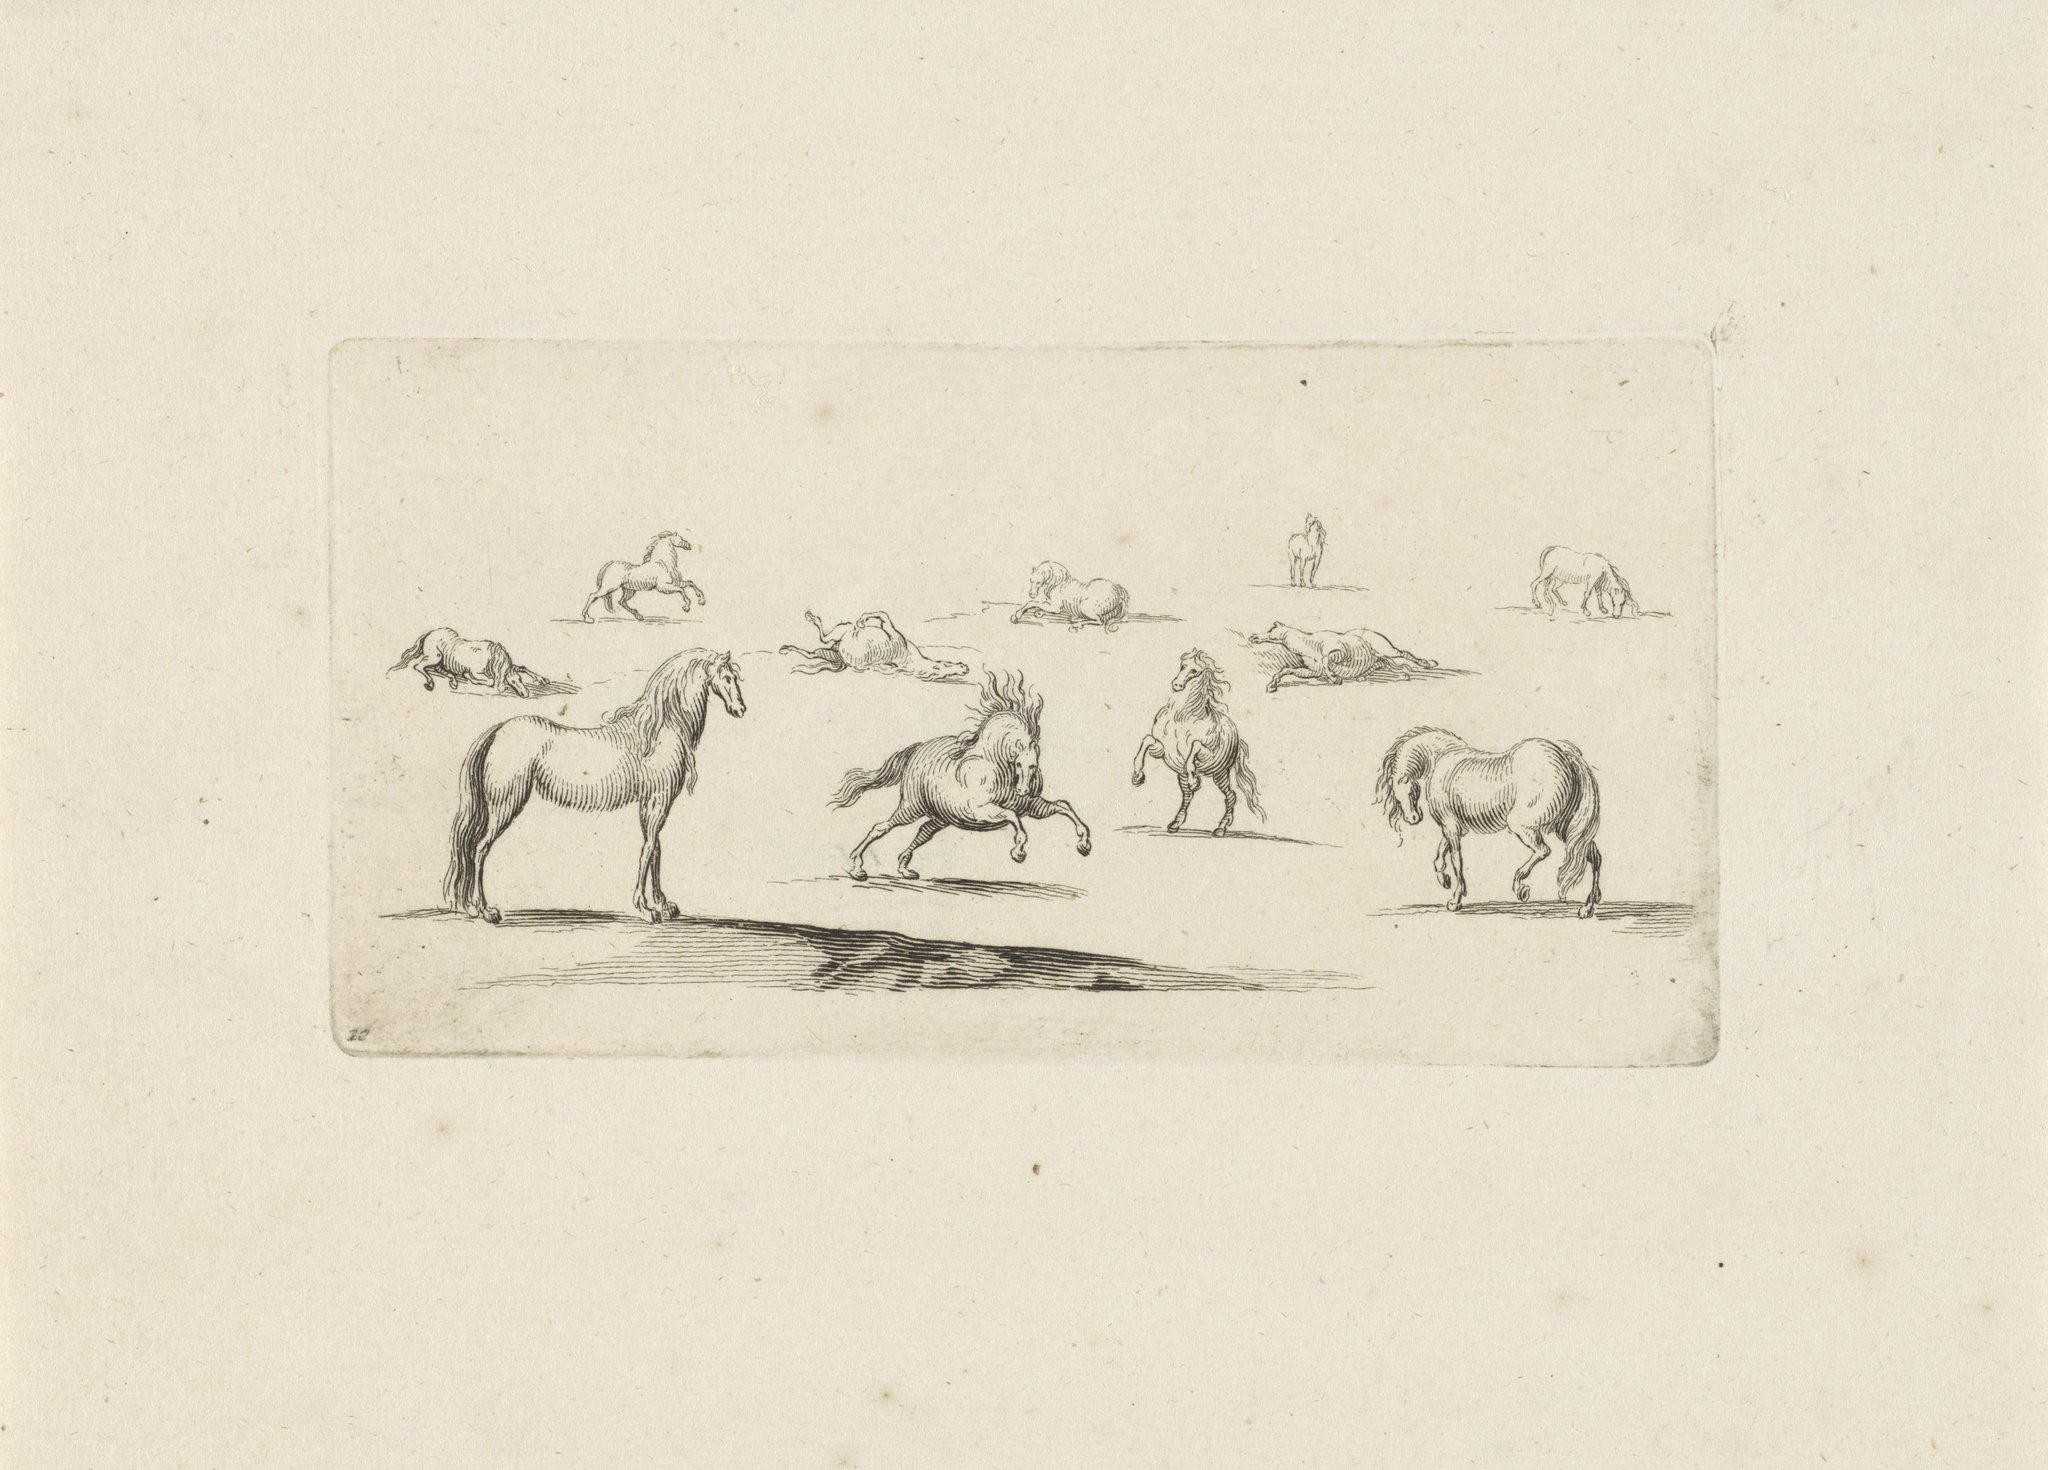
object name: print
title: Studiebladen met figuren en paarden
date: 1675-1711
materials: paper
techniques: etching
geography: amsterdam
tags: horse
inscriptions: collector's mark: Lugt 2228